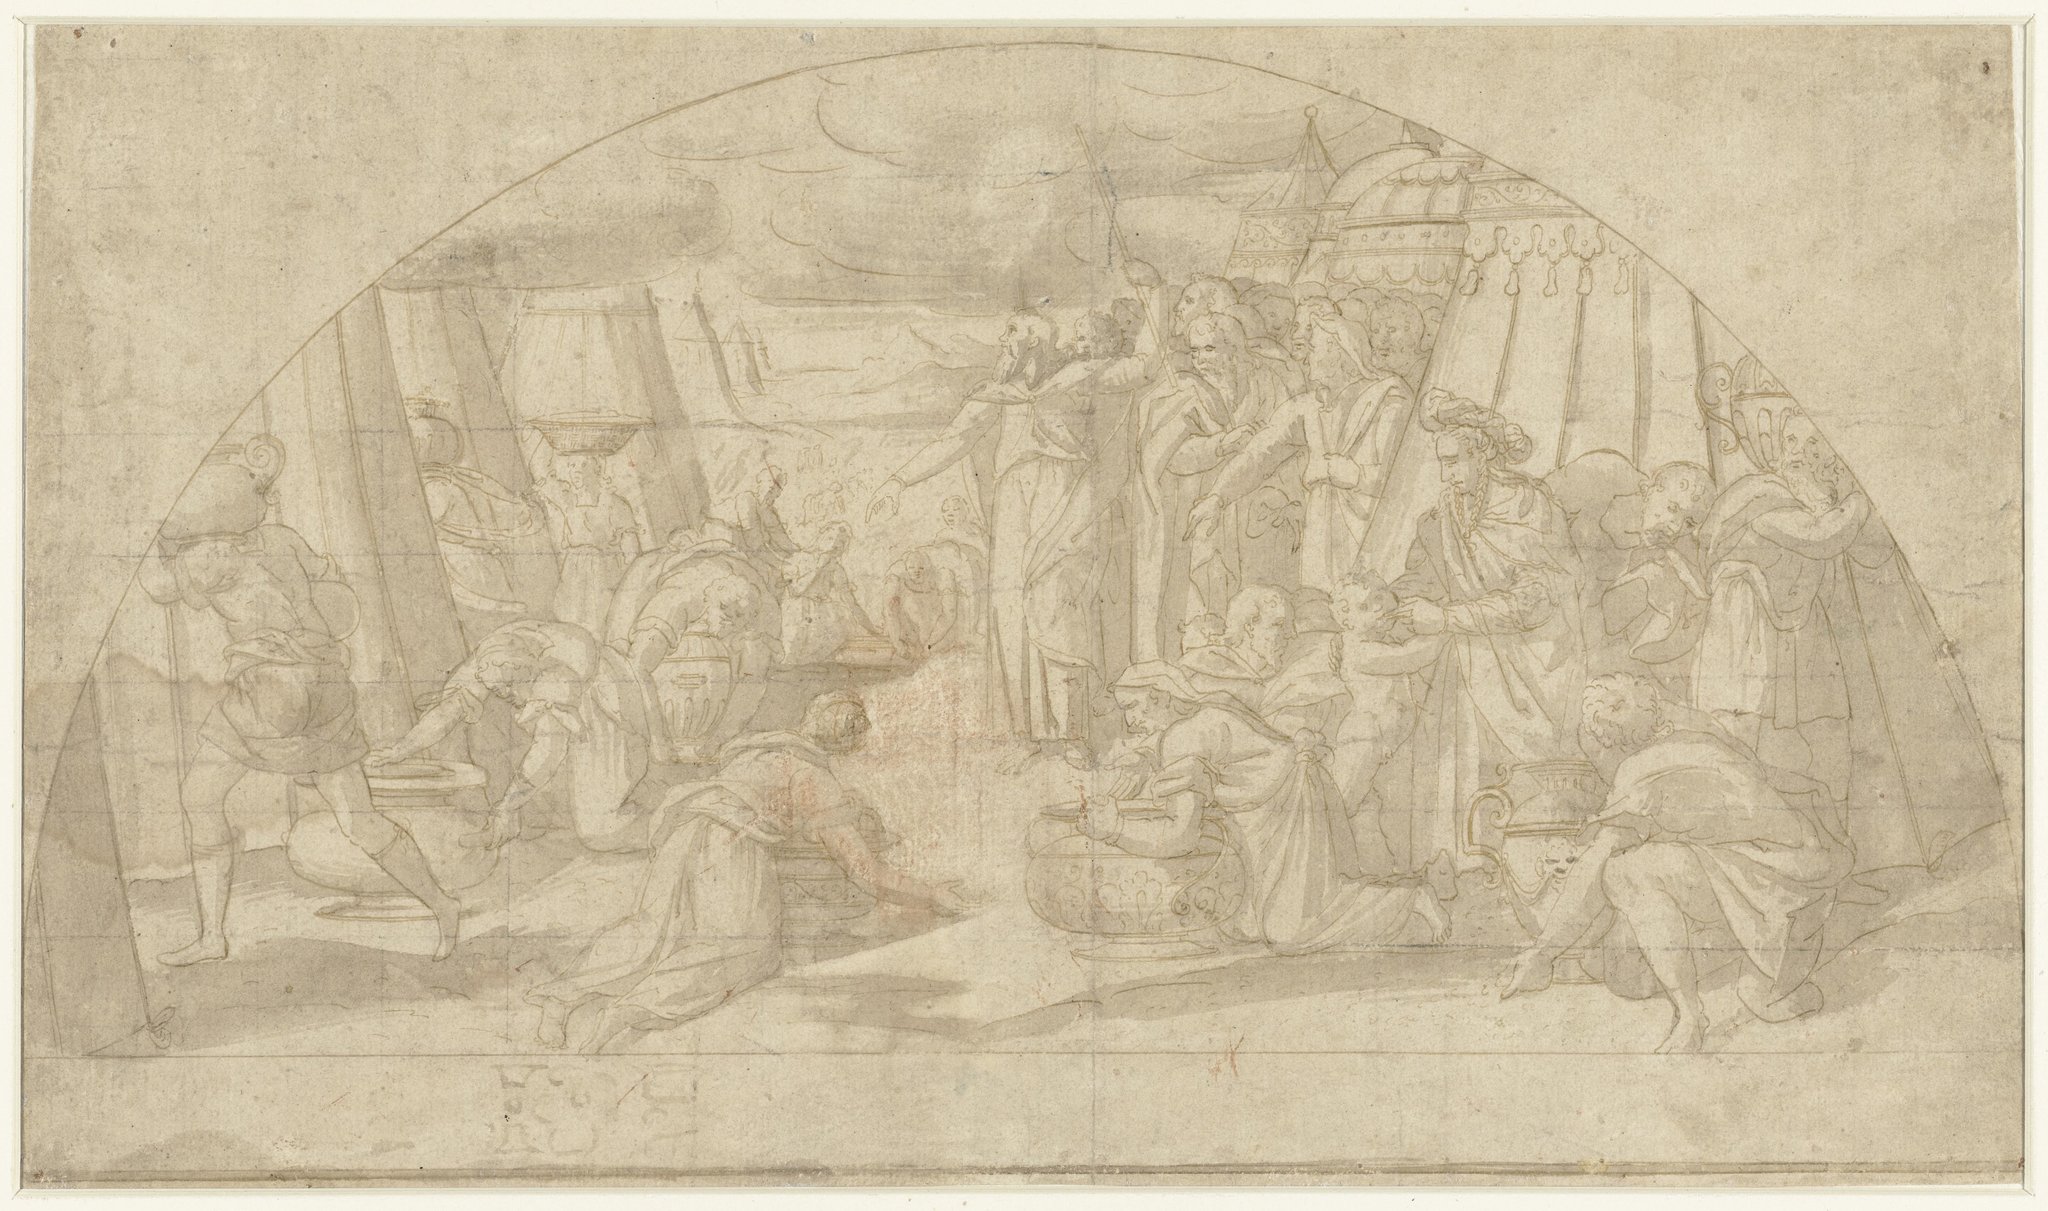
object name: drawing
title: Inzameling van het Manna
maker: Anonymous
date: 1600-1625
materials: ink, paper, pencil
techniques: brush, pen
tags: the gathering of manna (in baskets and pots)